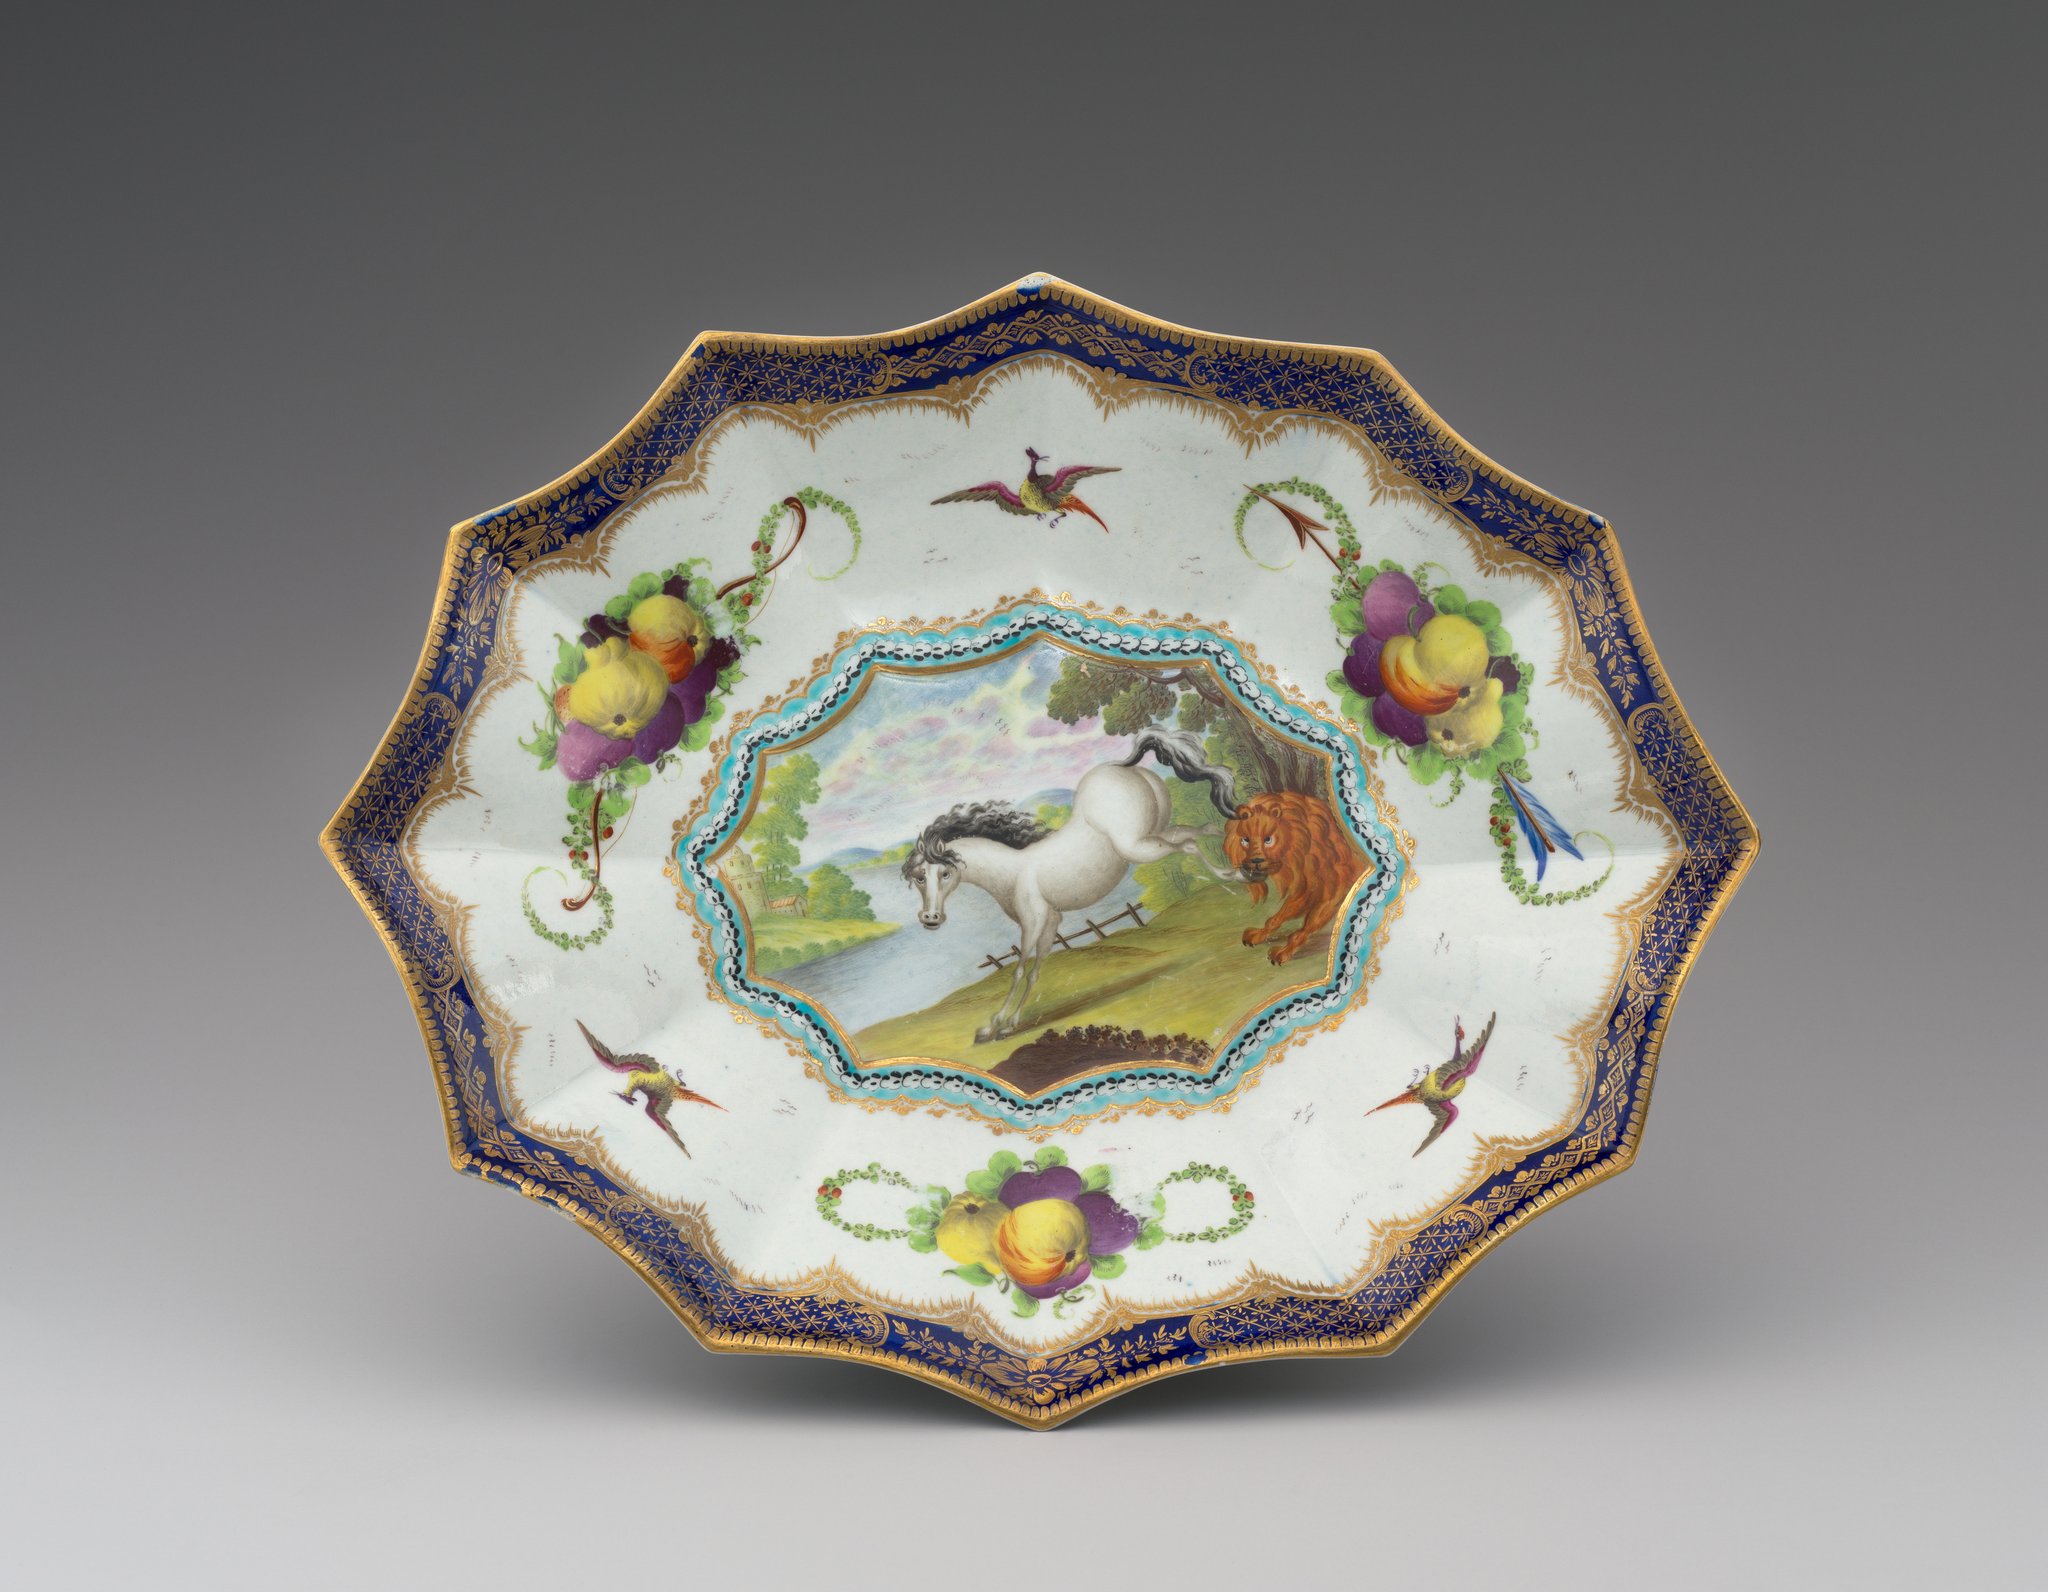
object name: dish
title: Dish (one of a pair)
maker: worcester factory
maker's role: factory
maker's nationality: british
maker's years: 1751-2008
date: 1770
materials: soft paste porcelain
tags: horses